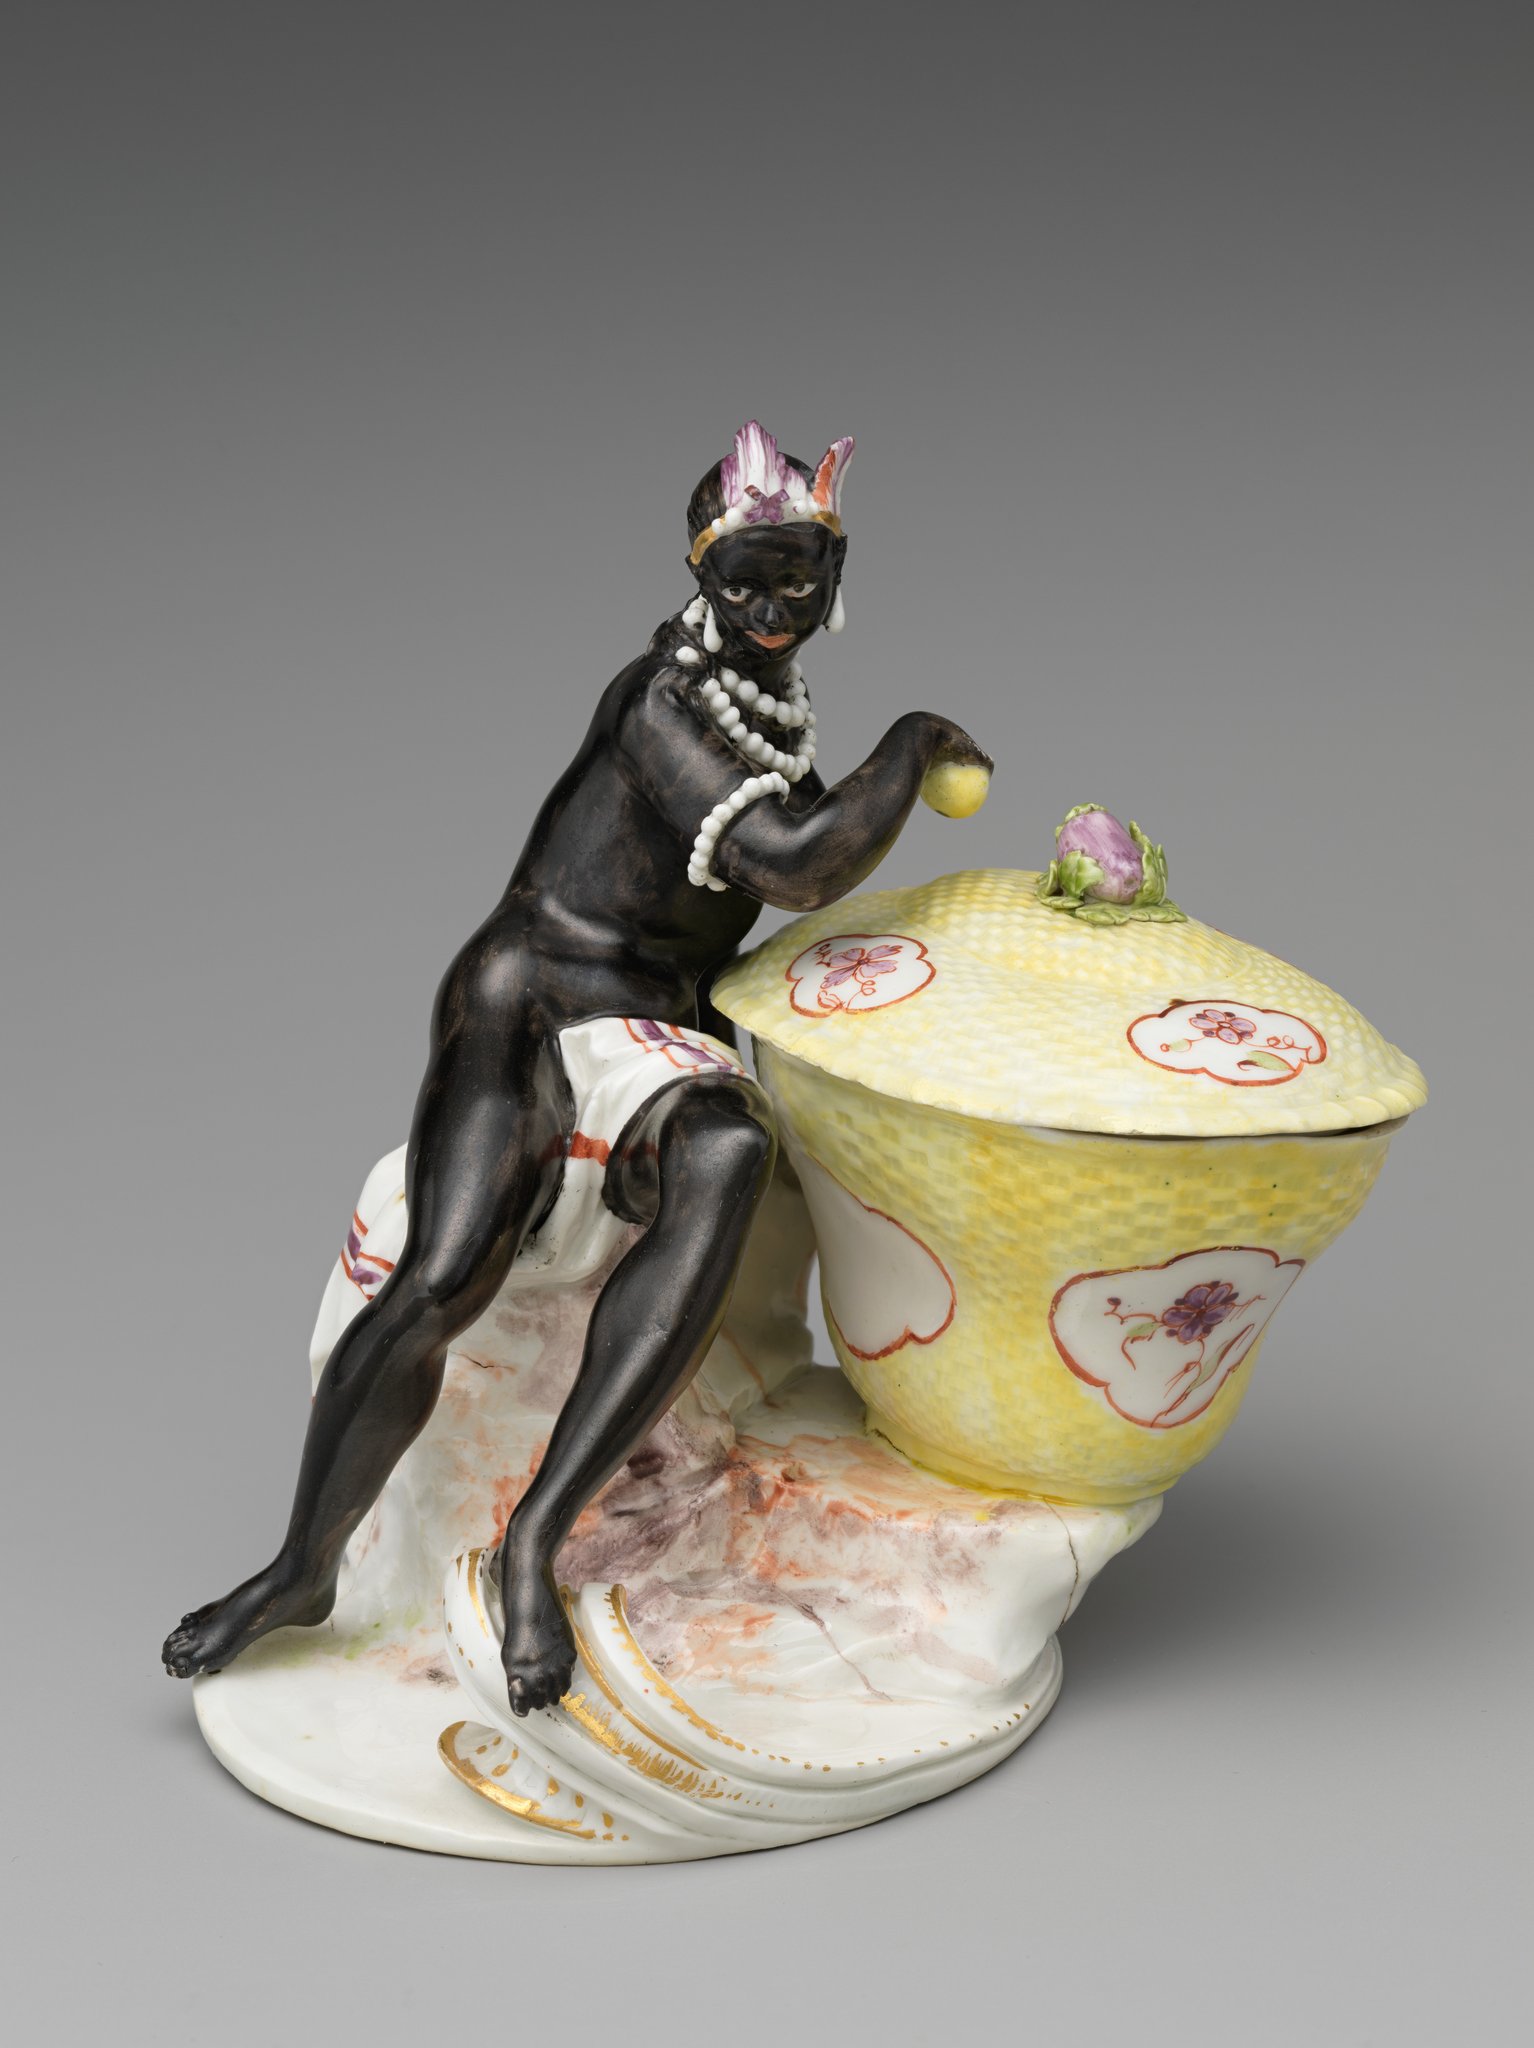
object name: sugar box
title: Sugar box (one of a pair)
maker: nymphenburg porcelain manufactory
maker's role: manufactory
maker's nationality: german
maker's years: 1747-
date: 1760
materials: hard paste porcelain